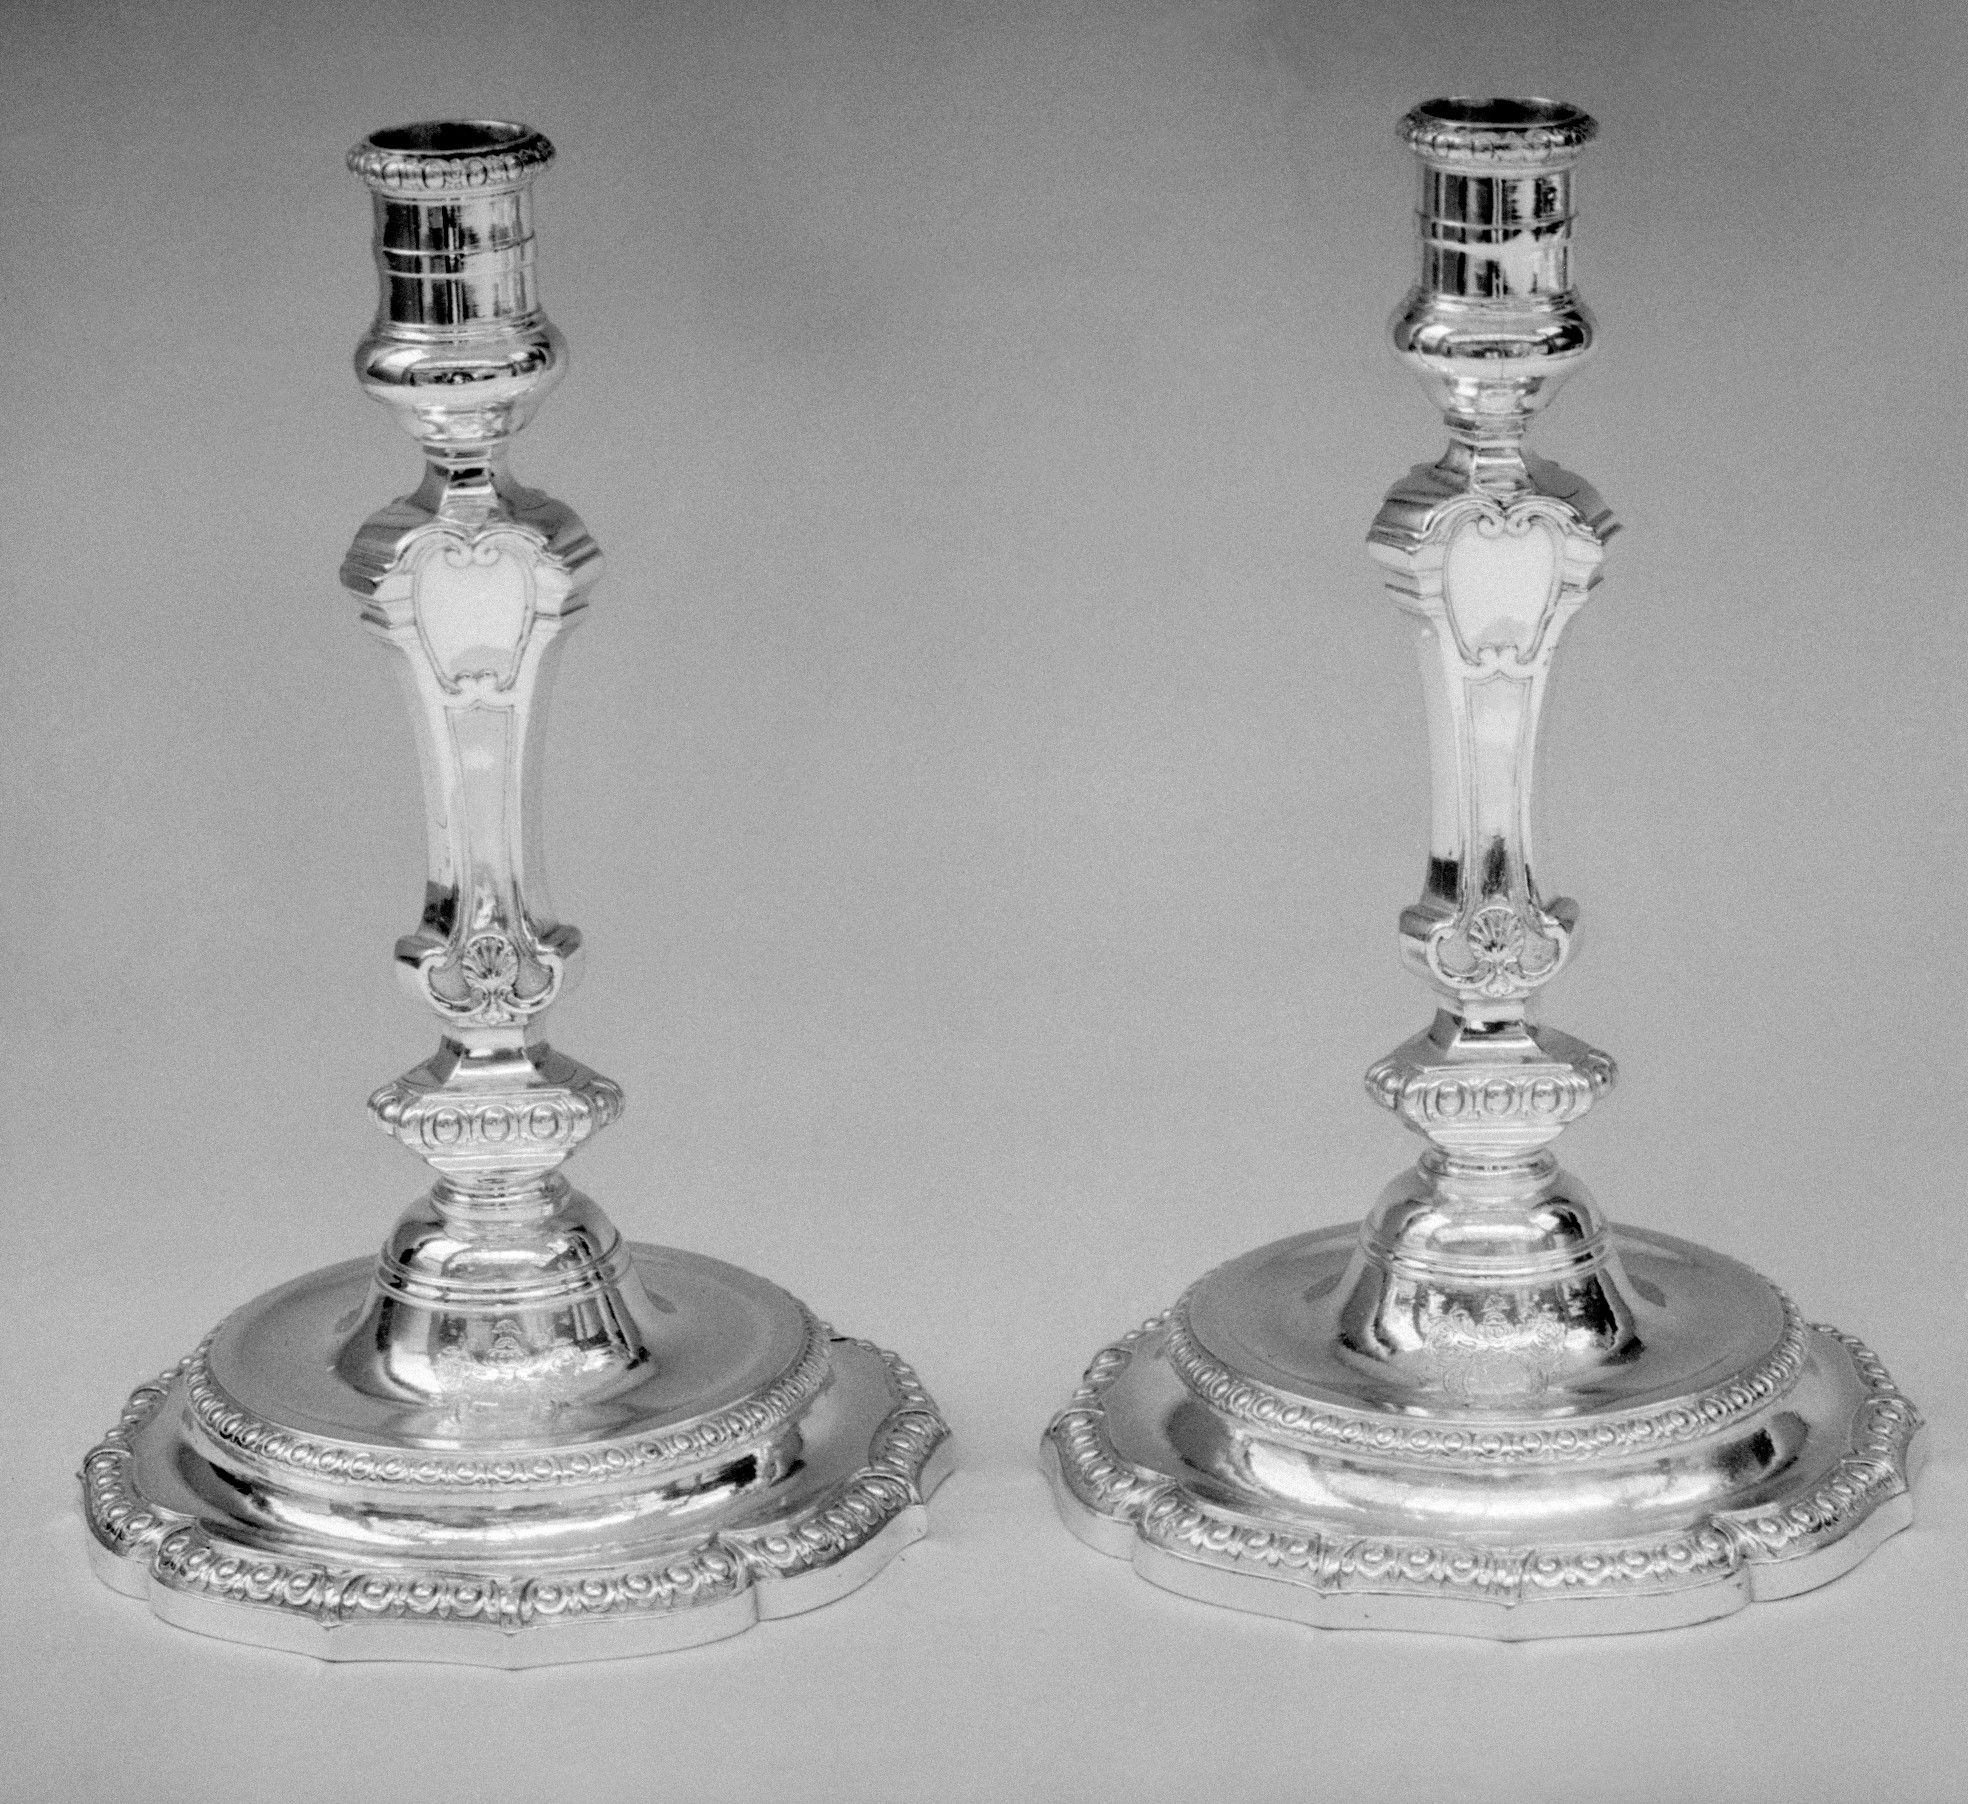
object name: candlestick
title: Pair of candlesticks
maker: gilles-claude gouel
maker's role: maker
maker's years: 1669-1769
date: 1729-1730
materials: silver